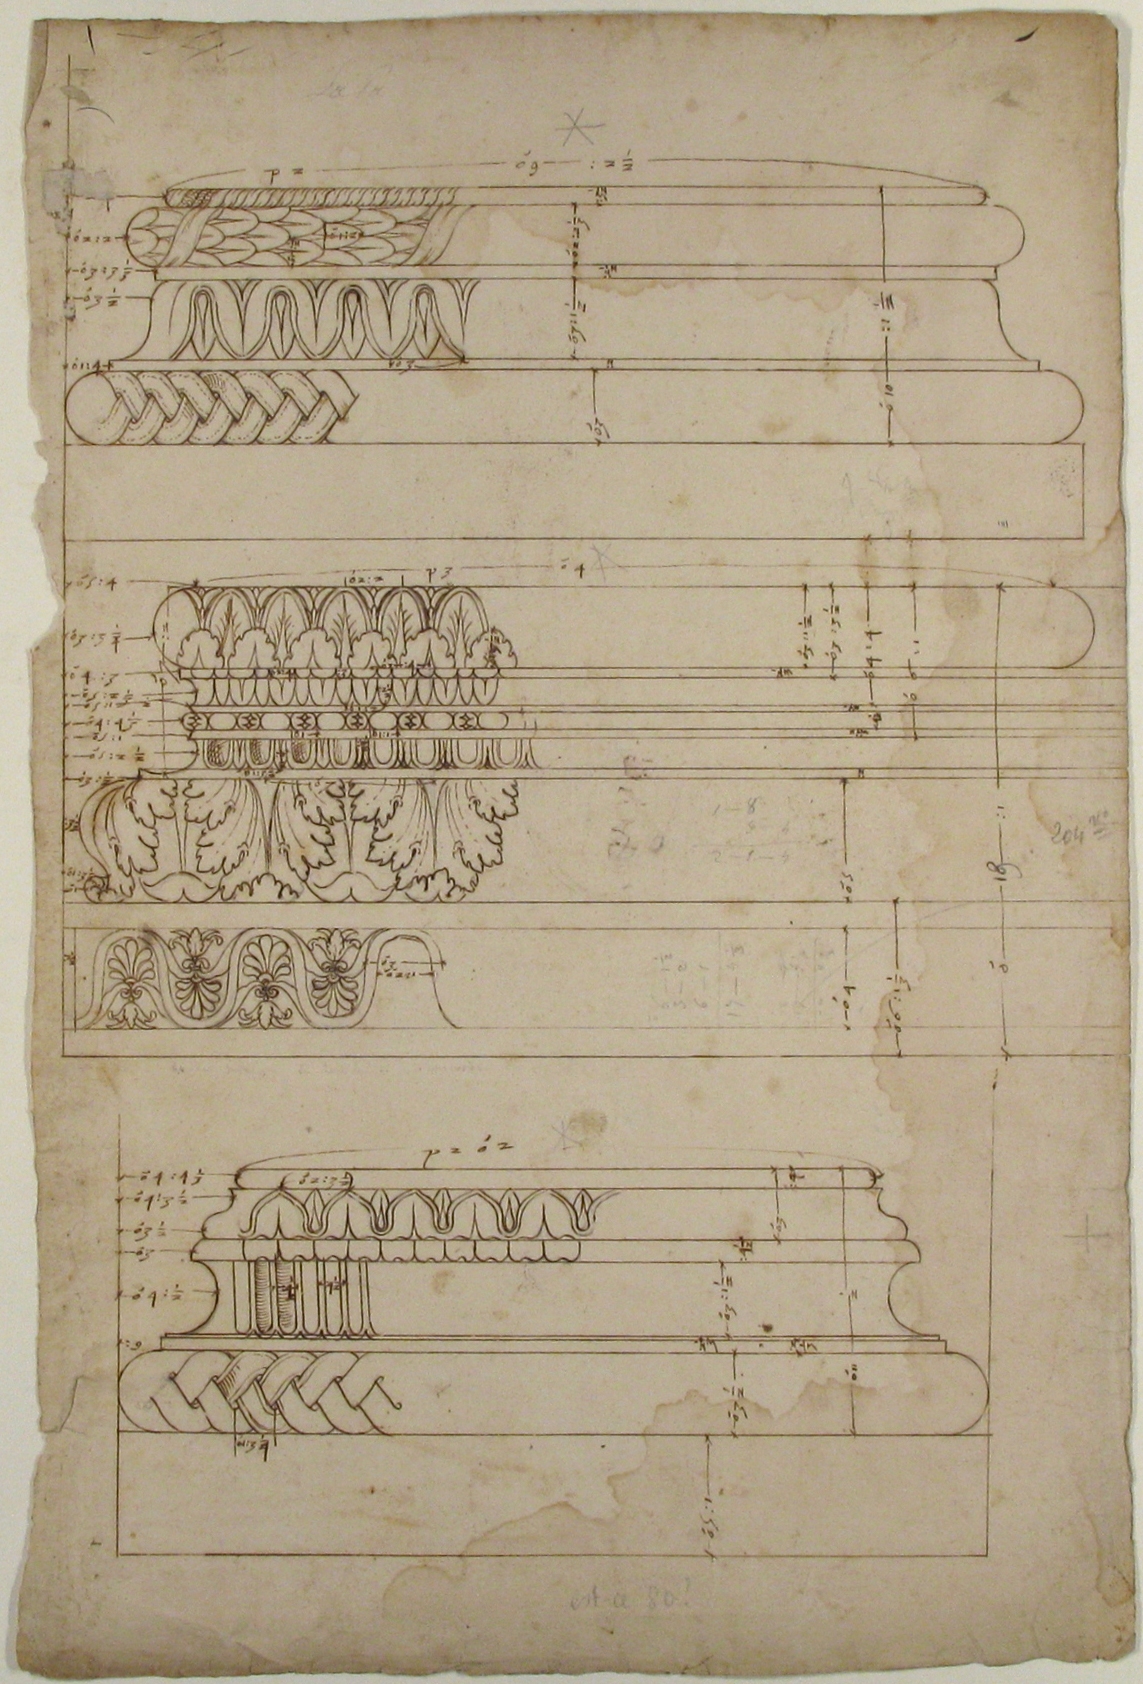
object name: collection ornament architecture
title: Unidentified, Composite base, elevation; Temple of Concordia, Composite base, elevation; Unidentified, Composite base, elevation (recto) blank (verso)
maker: anonymous, french, 16th century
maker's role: draftsman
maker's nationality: french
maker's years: 1500-1600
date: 1540-1560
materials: chalk, ink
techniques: incising